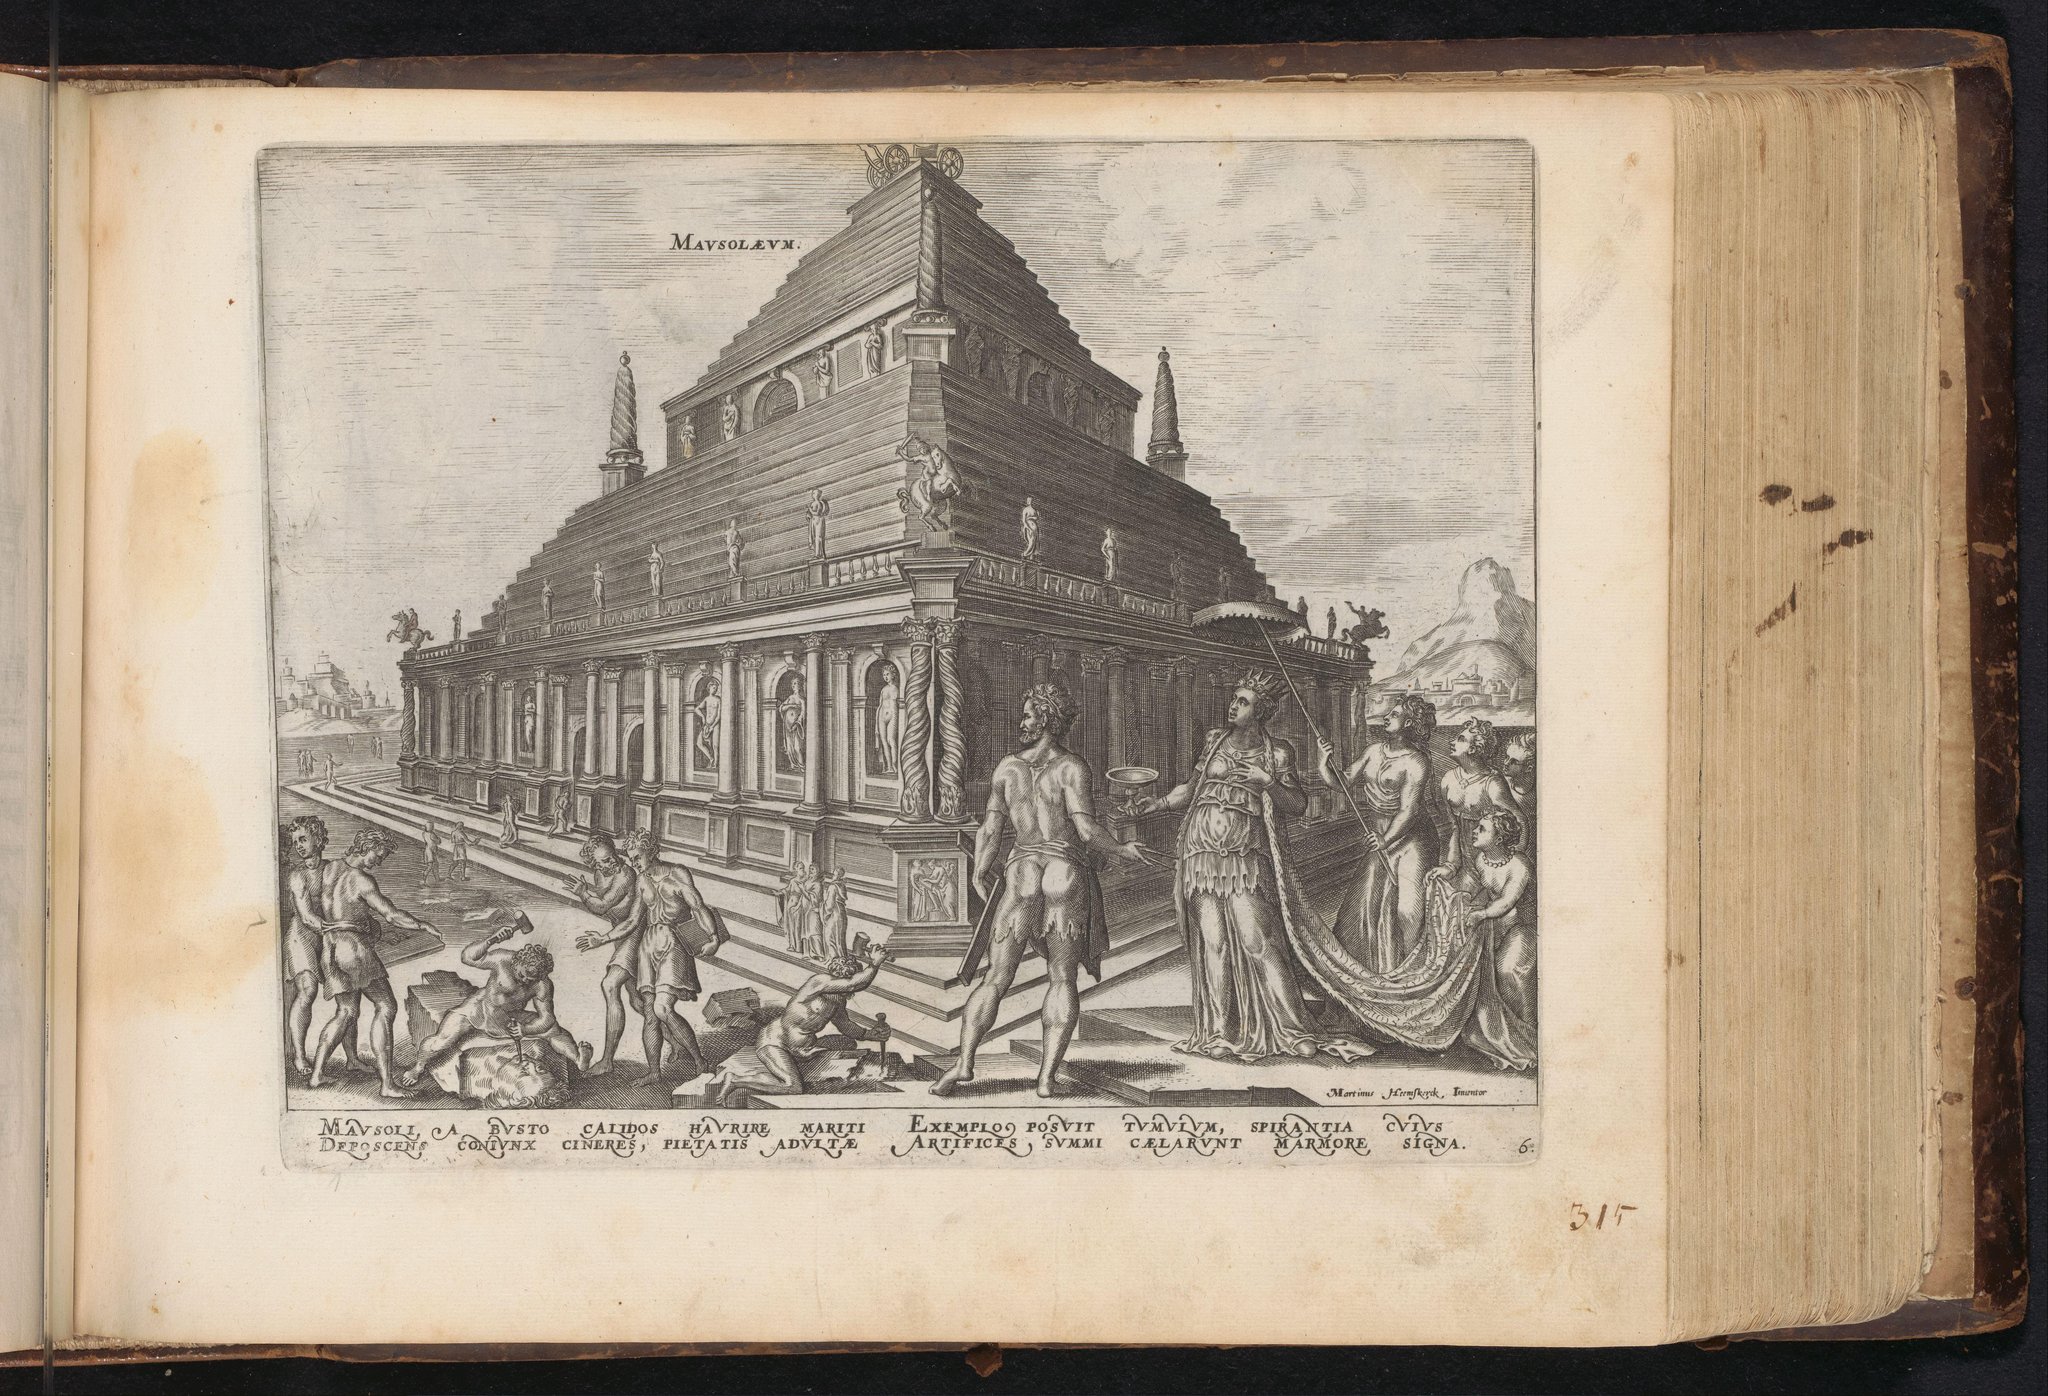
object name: album leaf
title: Van de Seven Wonderen der Wereldt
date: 1572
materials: paper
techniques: engraving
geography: alkmaar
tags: sculptor at work, artemisia erects a monument to the memory of her dead husband, mausoleum at halicarnassus (wonder of the world)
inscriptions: number: ‘315’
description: Het mausoleum van Halicarnassus, de graftombe van koning Mausolus, een Perzische stadsvorst van Halicarnassus uit de 4e eeuw v. Chr. Het werd na zijn dood in 353 v. Chr. gebouwd in opdracht van zijn weduwe, koningin Artemisa. Het graf heeft een rechthoekige vorm en bovenop het bouwsel staat een strijdwagen. Op de voorgrond de koningin onder een parasol, begeleid door bedienden. Linksvoor zijn beeldhouwers een beeld aan het houwen. Onder de voorstelling een vers in het Latijn. Deze prent maakt deel uit van een album.